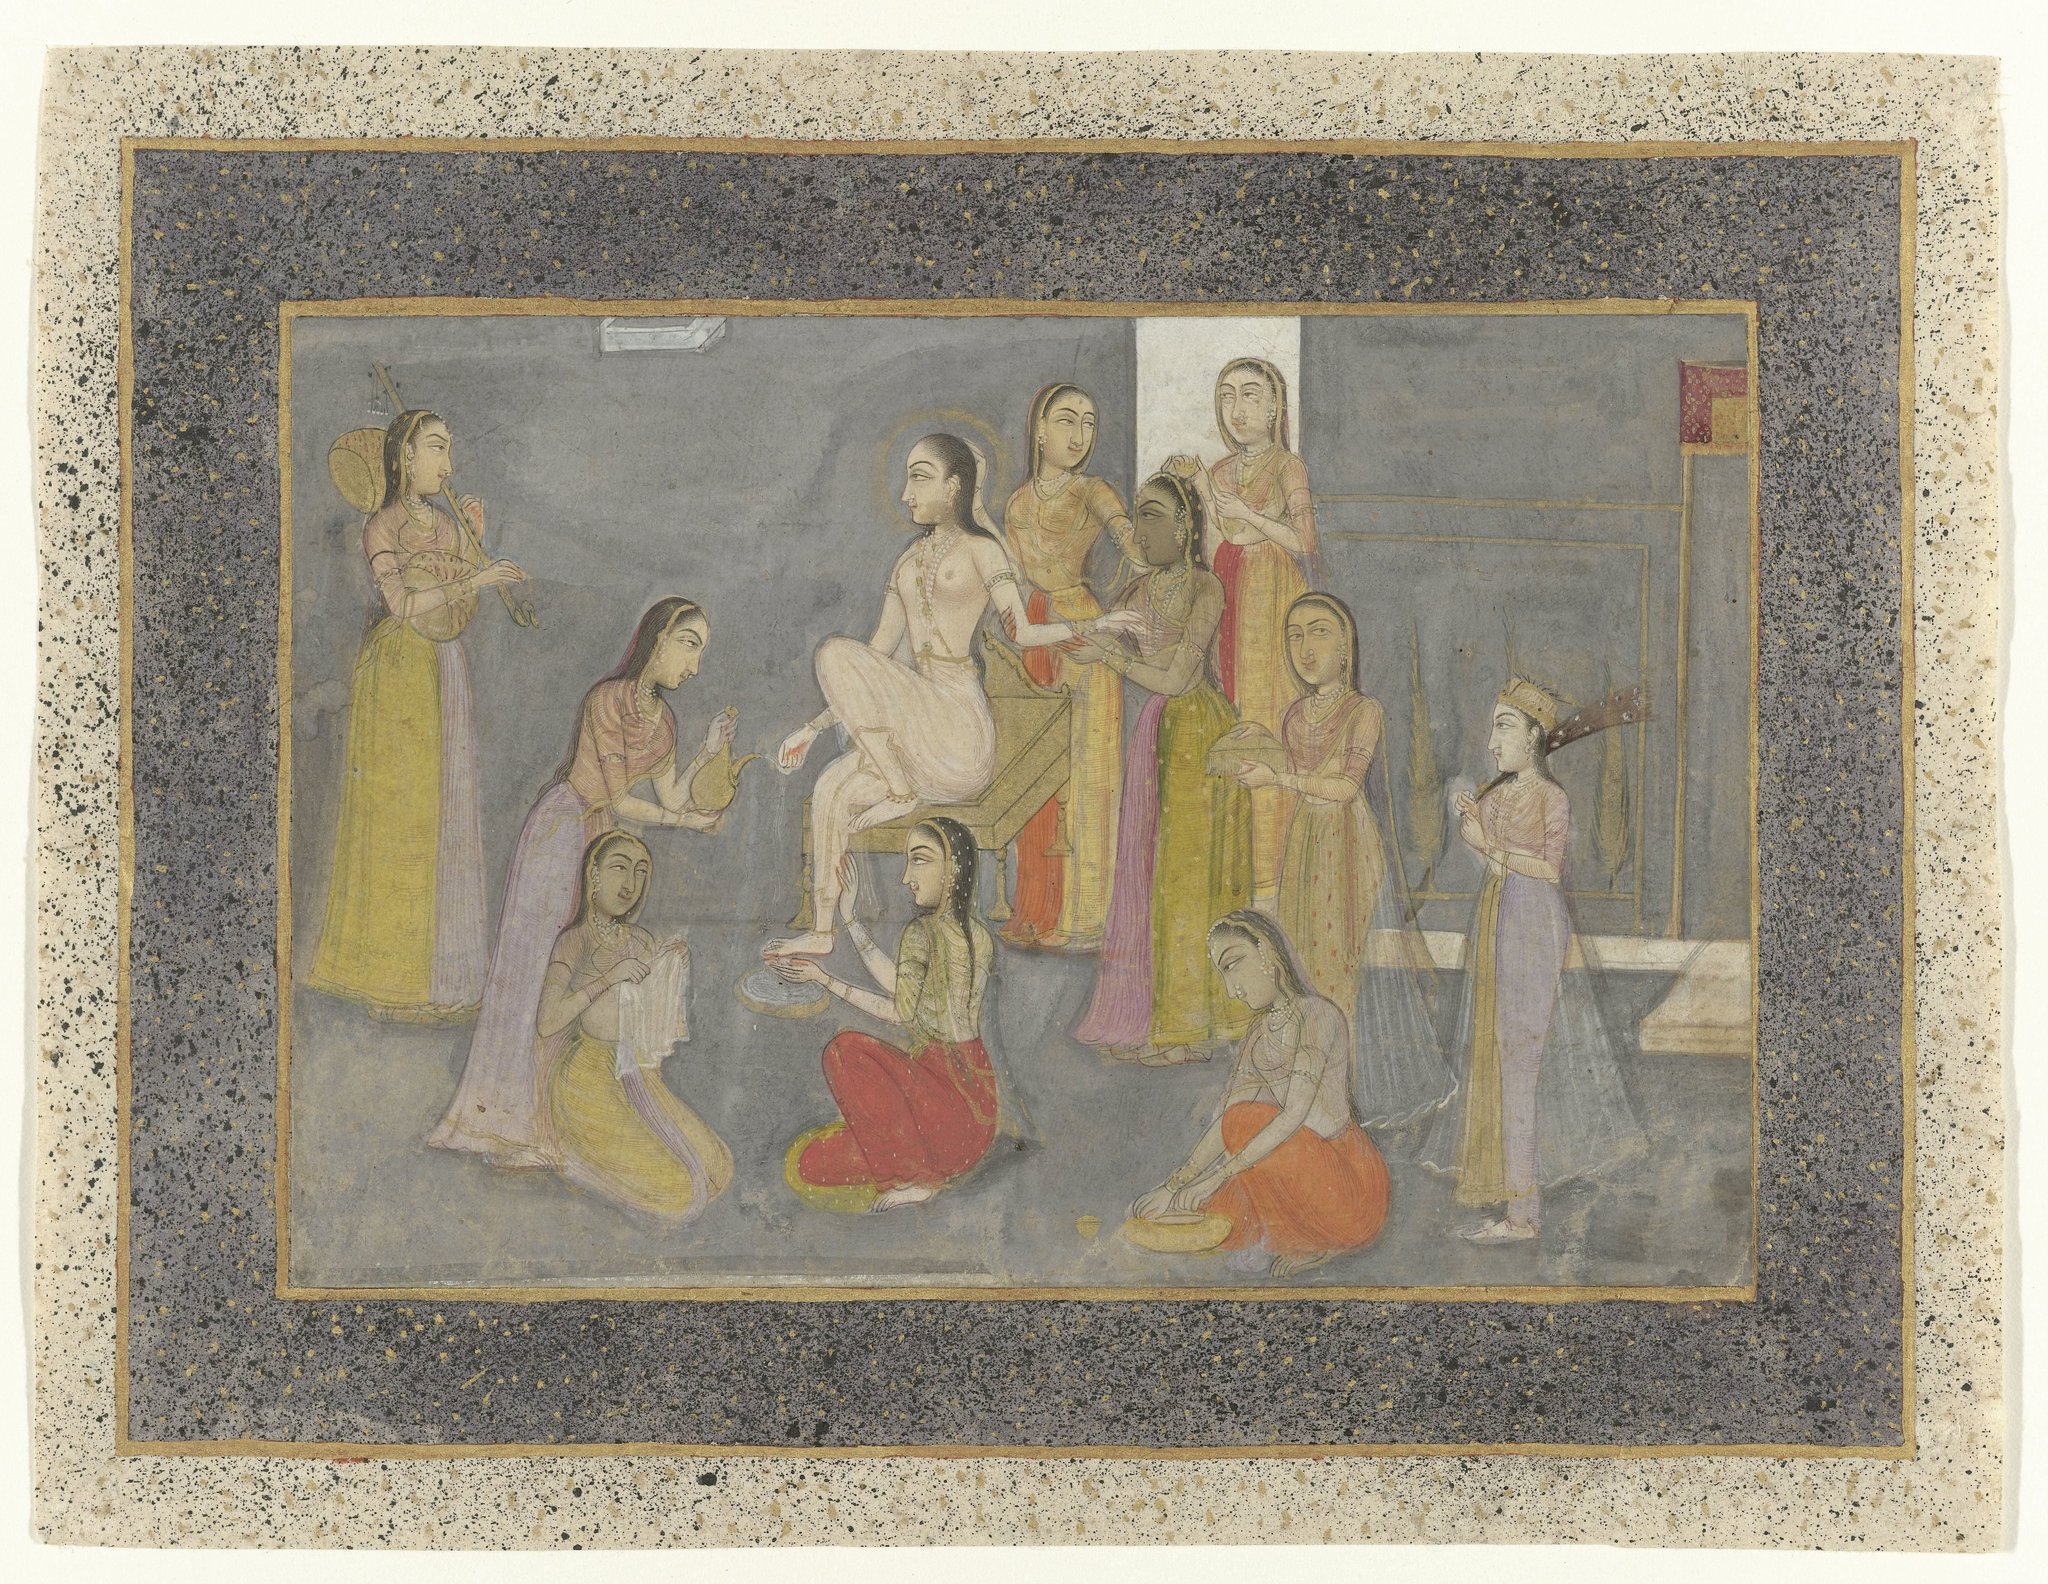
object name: indian miniature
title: Toilet van een prinses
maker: Anonymous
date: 1526-1857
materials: paint, gouache, paper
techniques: brush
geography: india